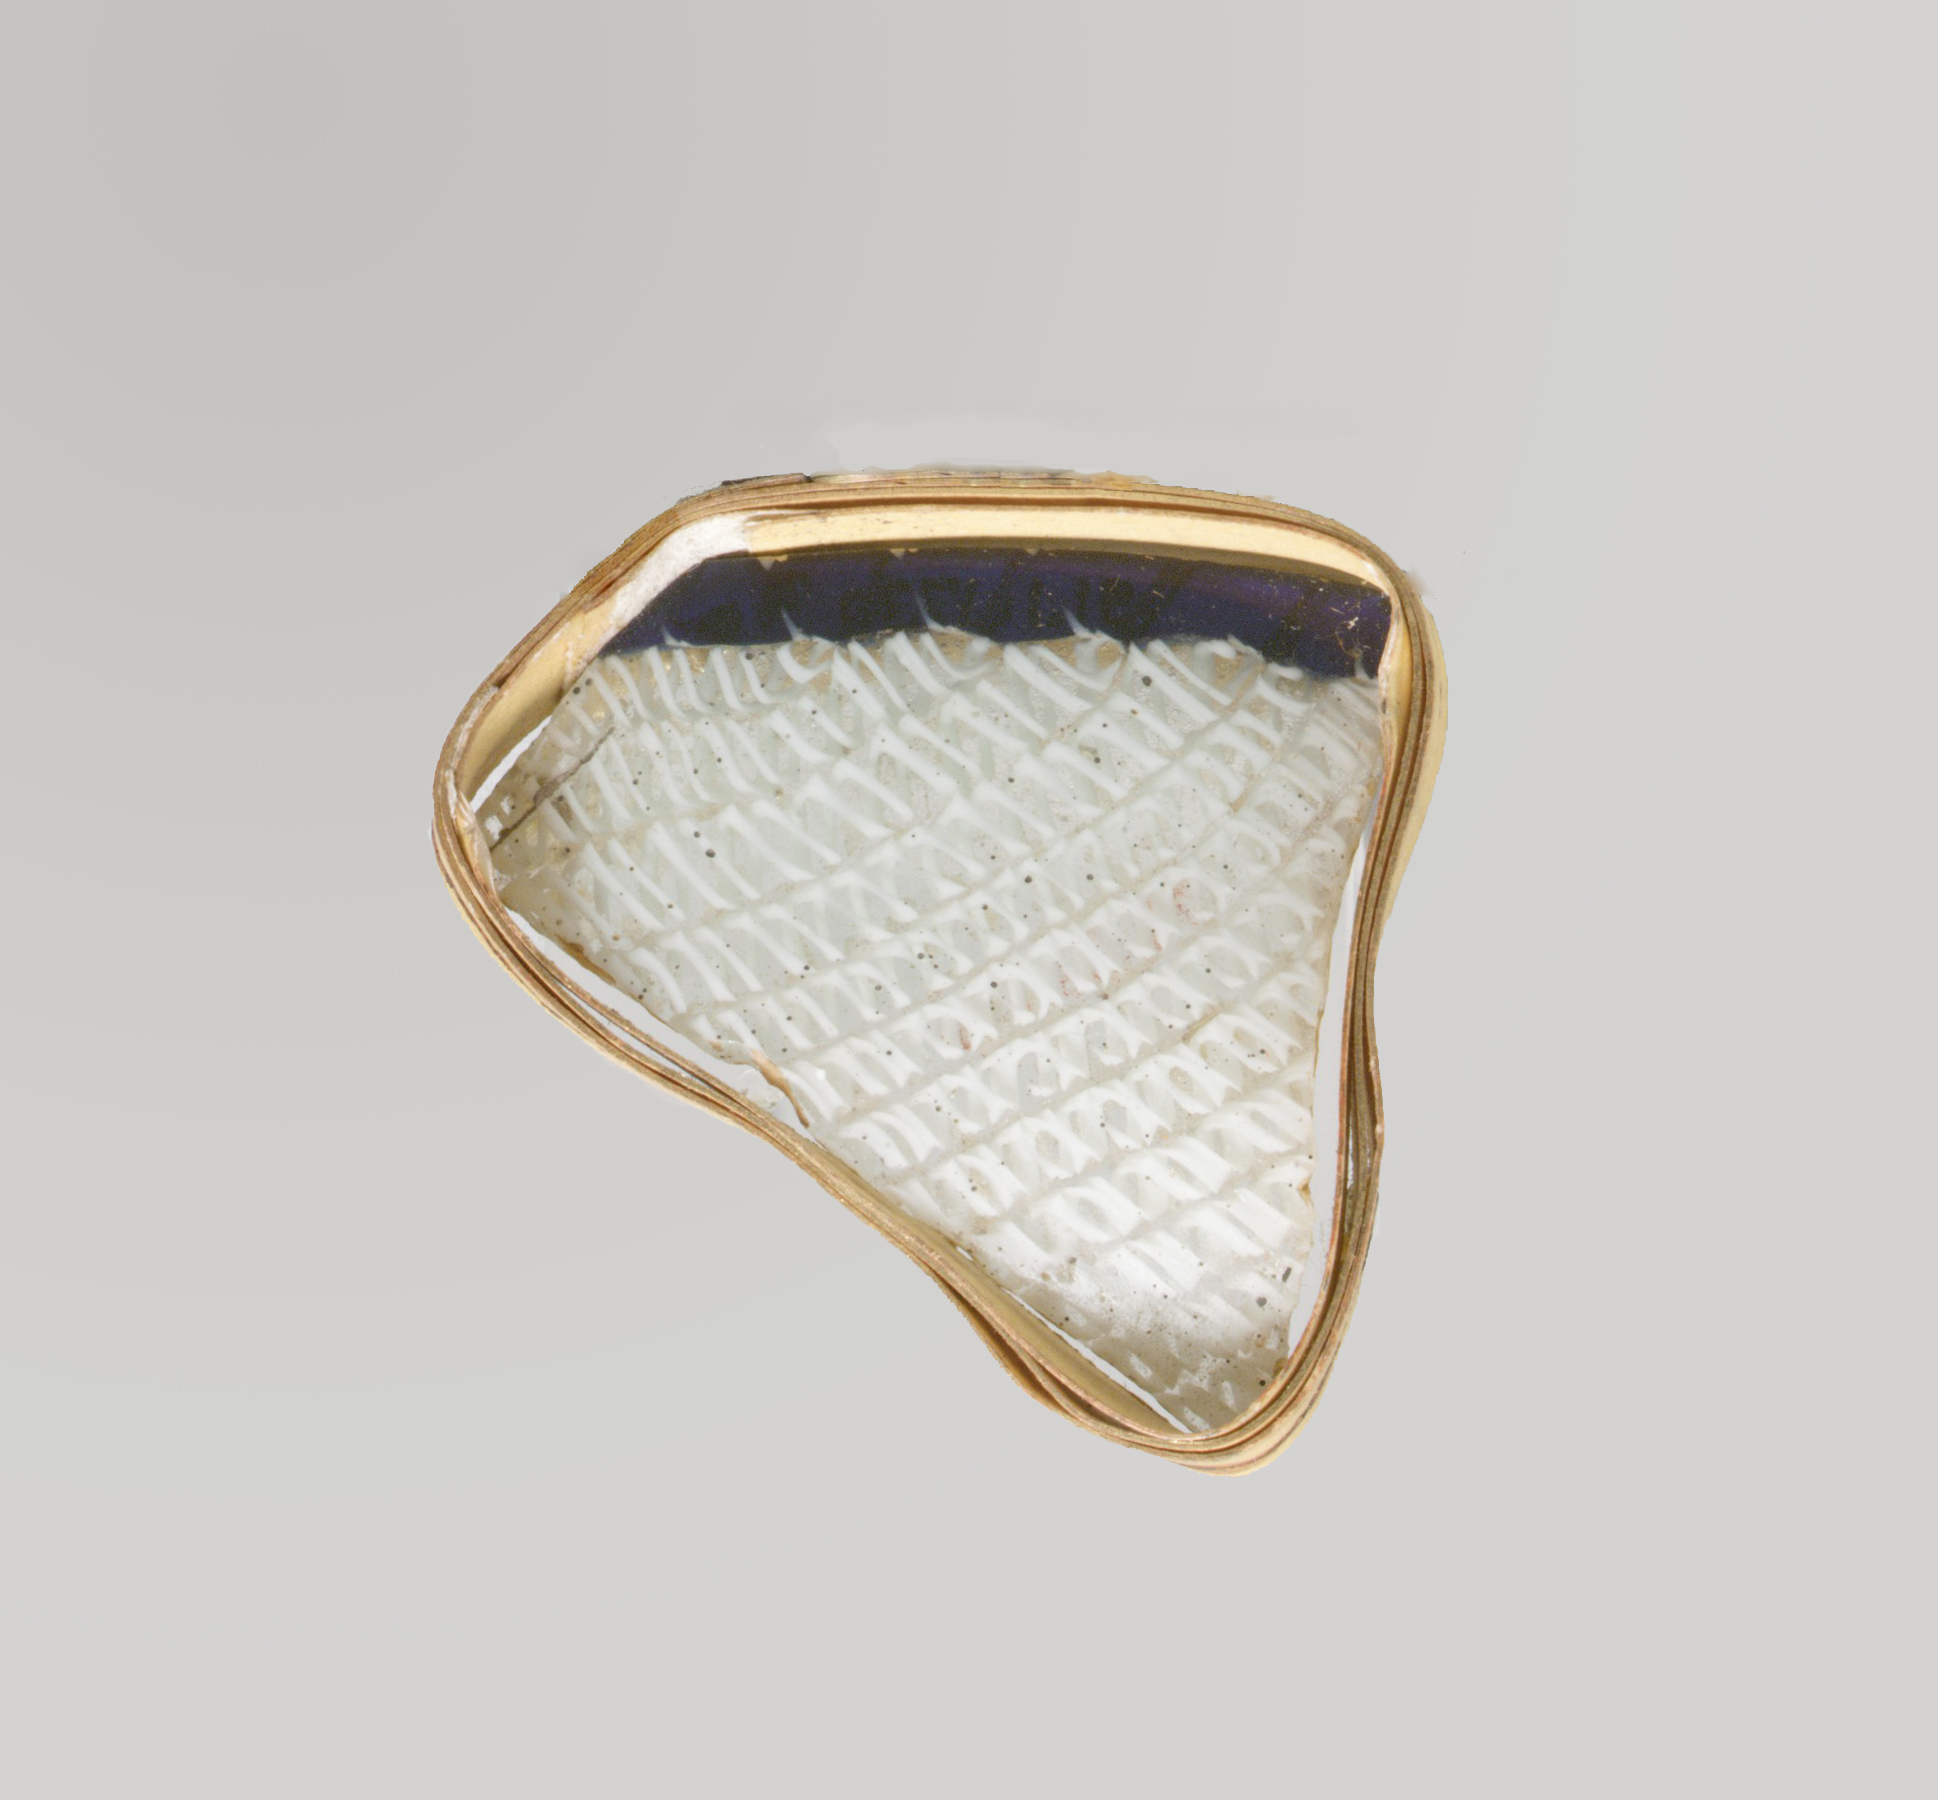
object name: fragment, network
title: Glass network mosaic bowl fragment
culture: roman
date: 34 BCE-33 CE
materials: glass